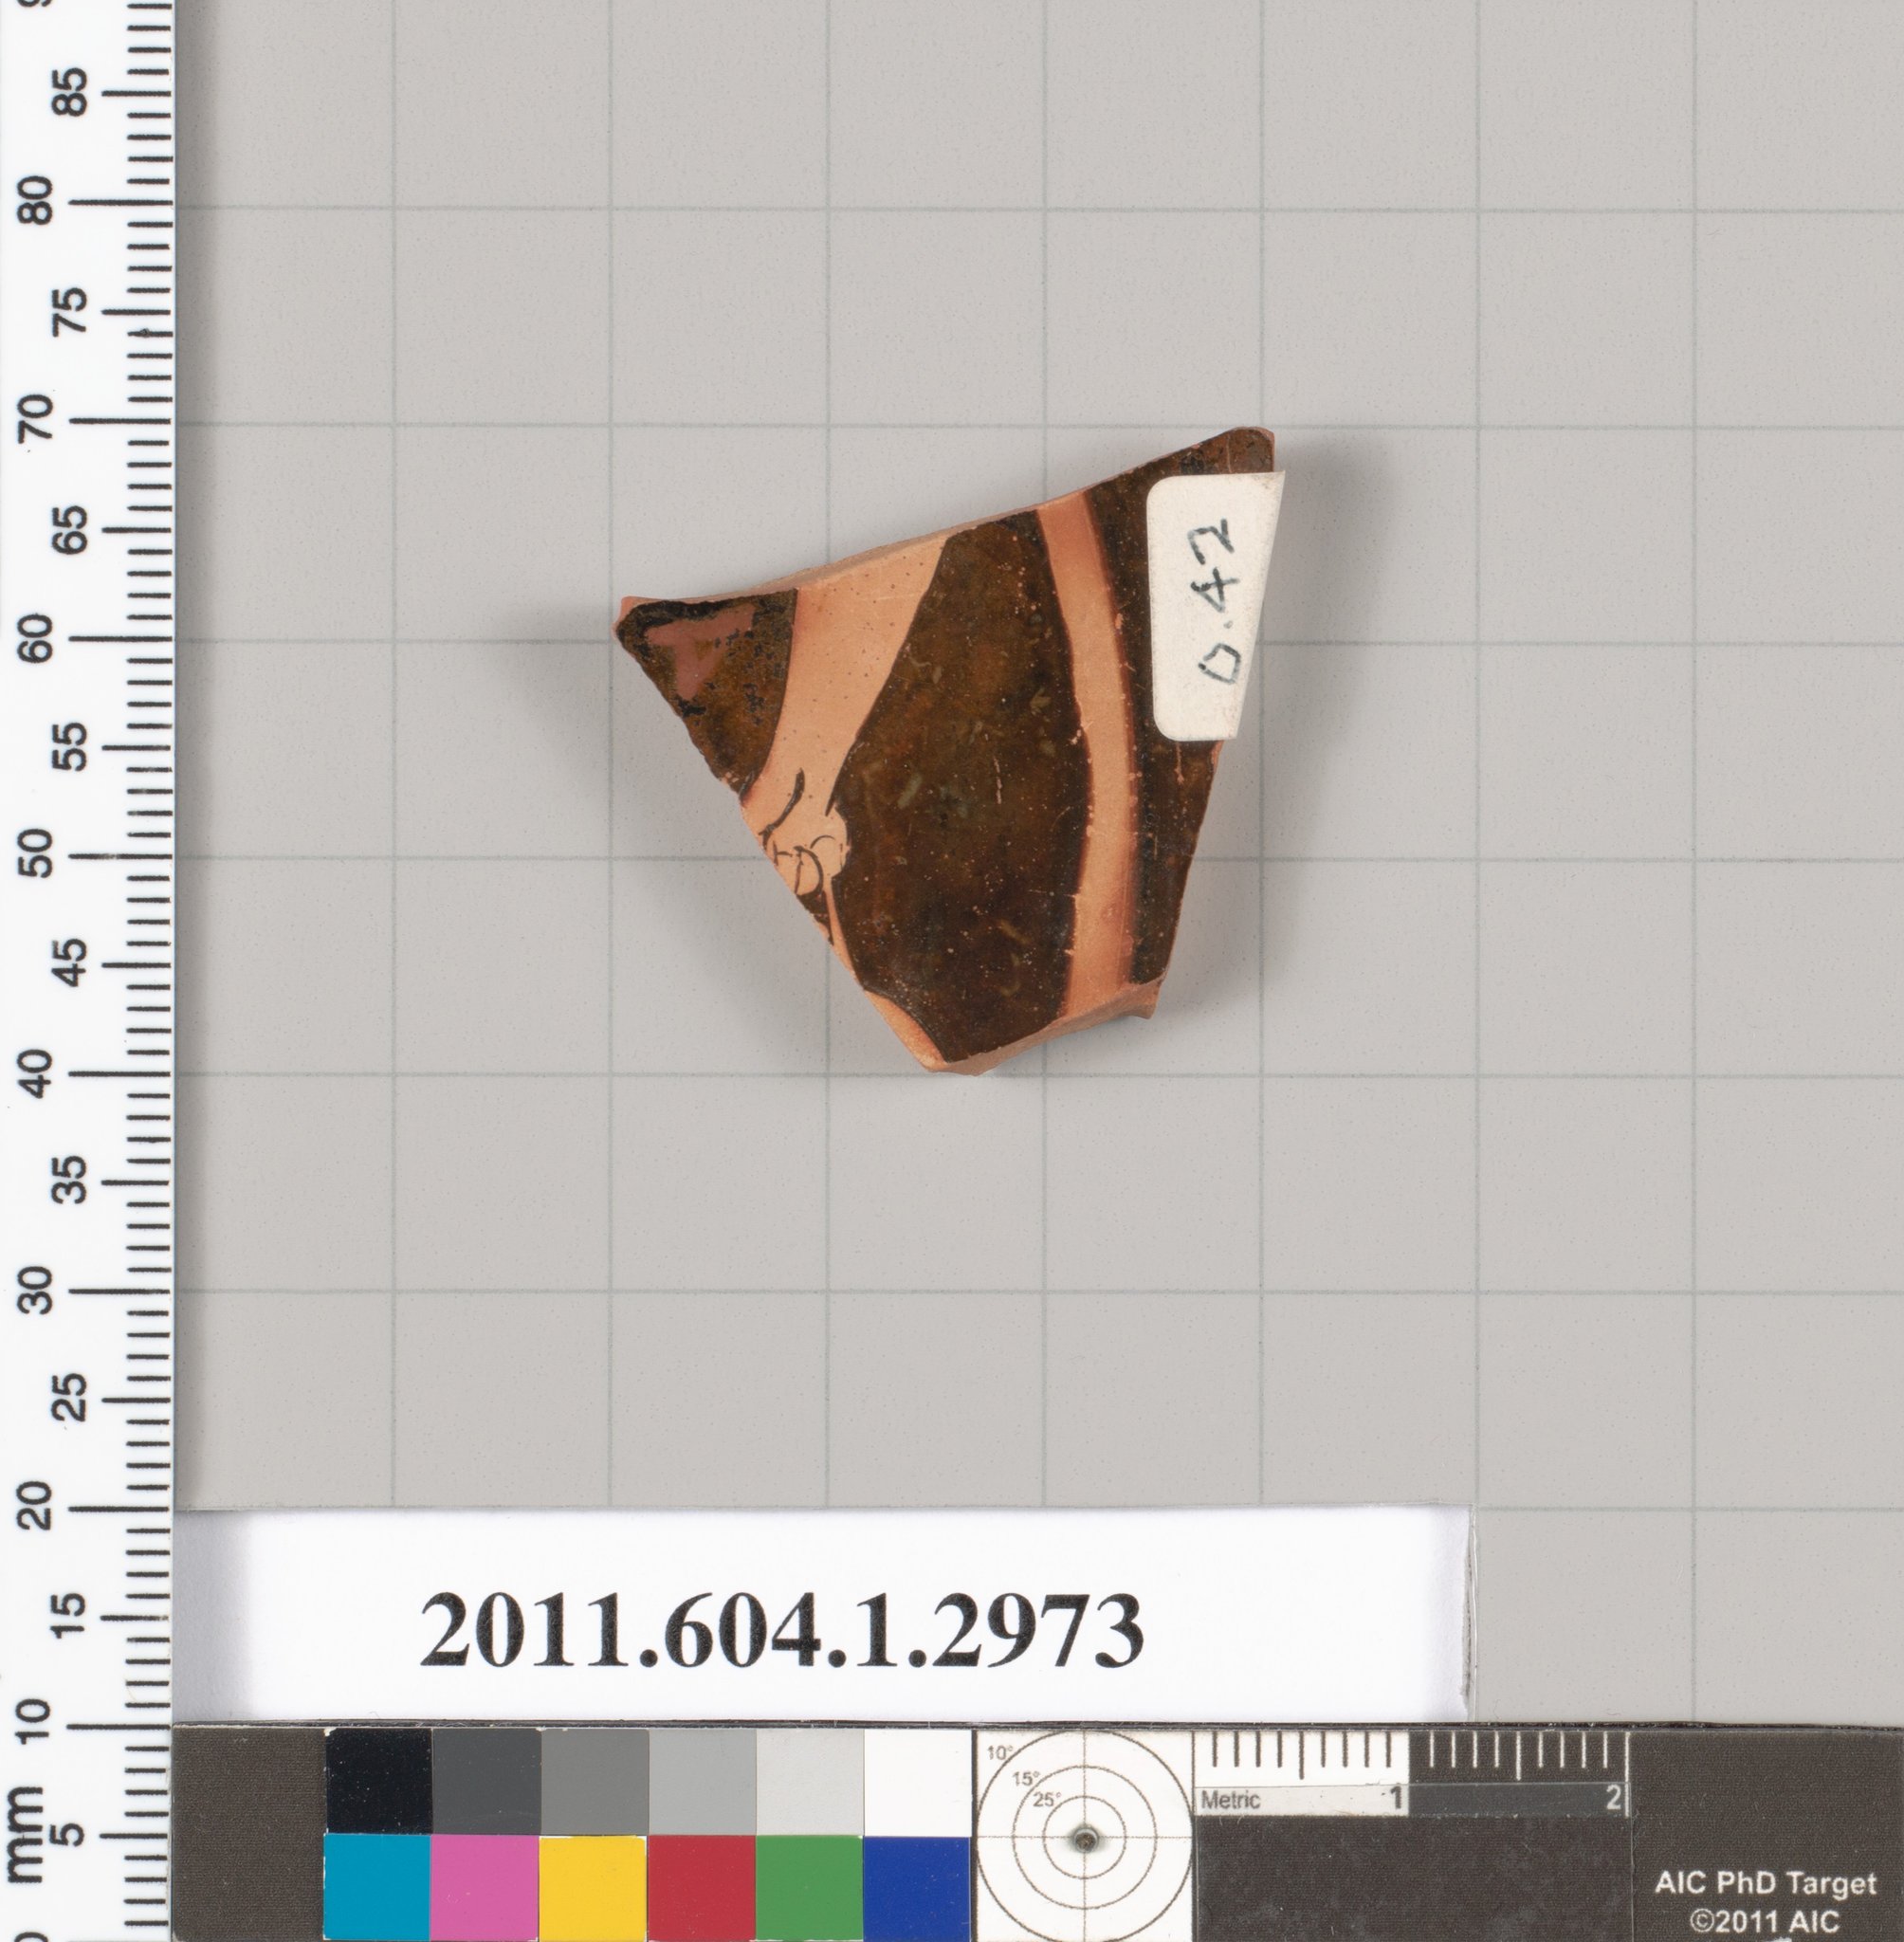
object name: kylix fragment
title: Terracotta fragment of a kylix (drinking cup)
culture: greek, attic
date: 520-500 BCE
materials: terracotta